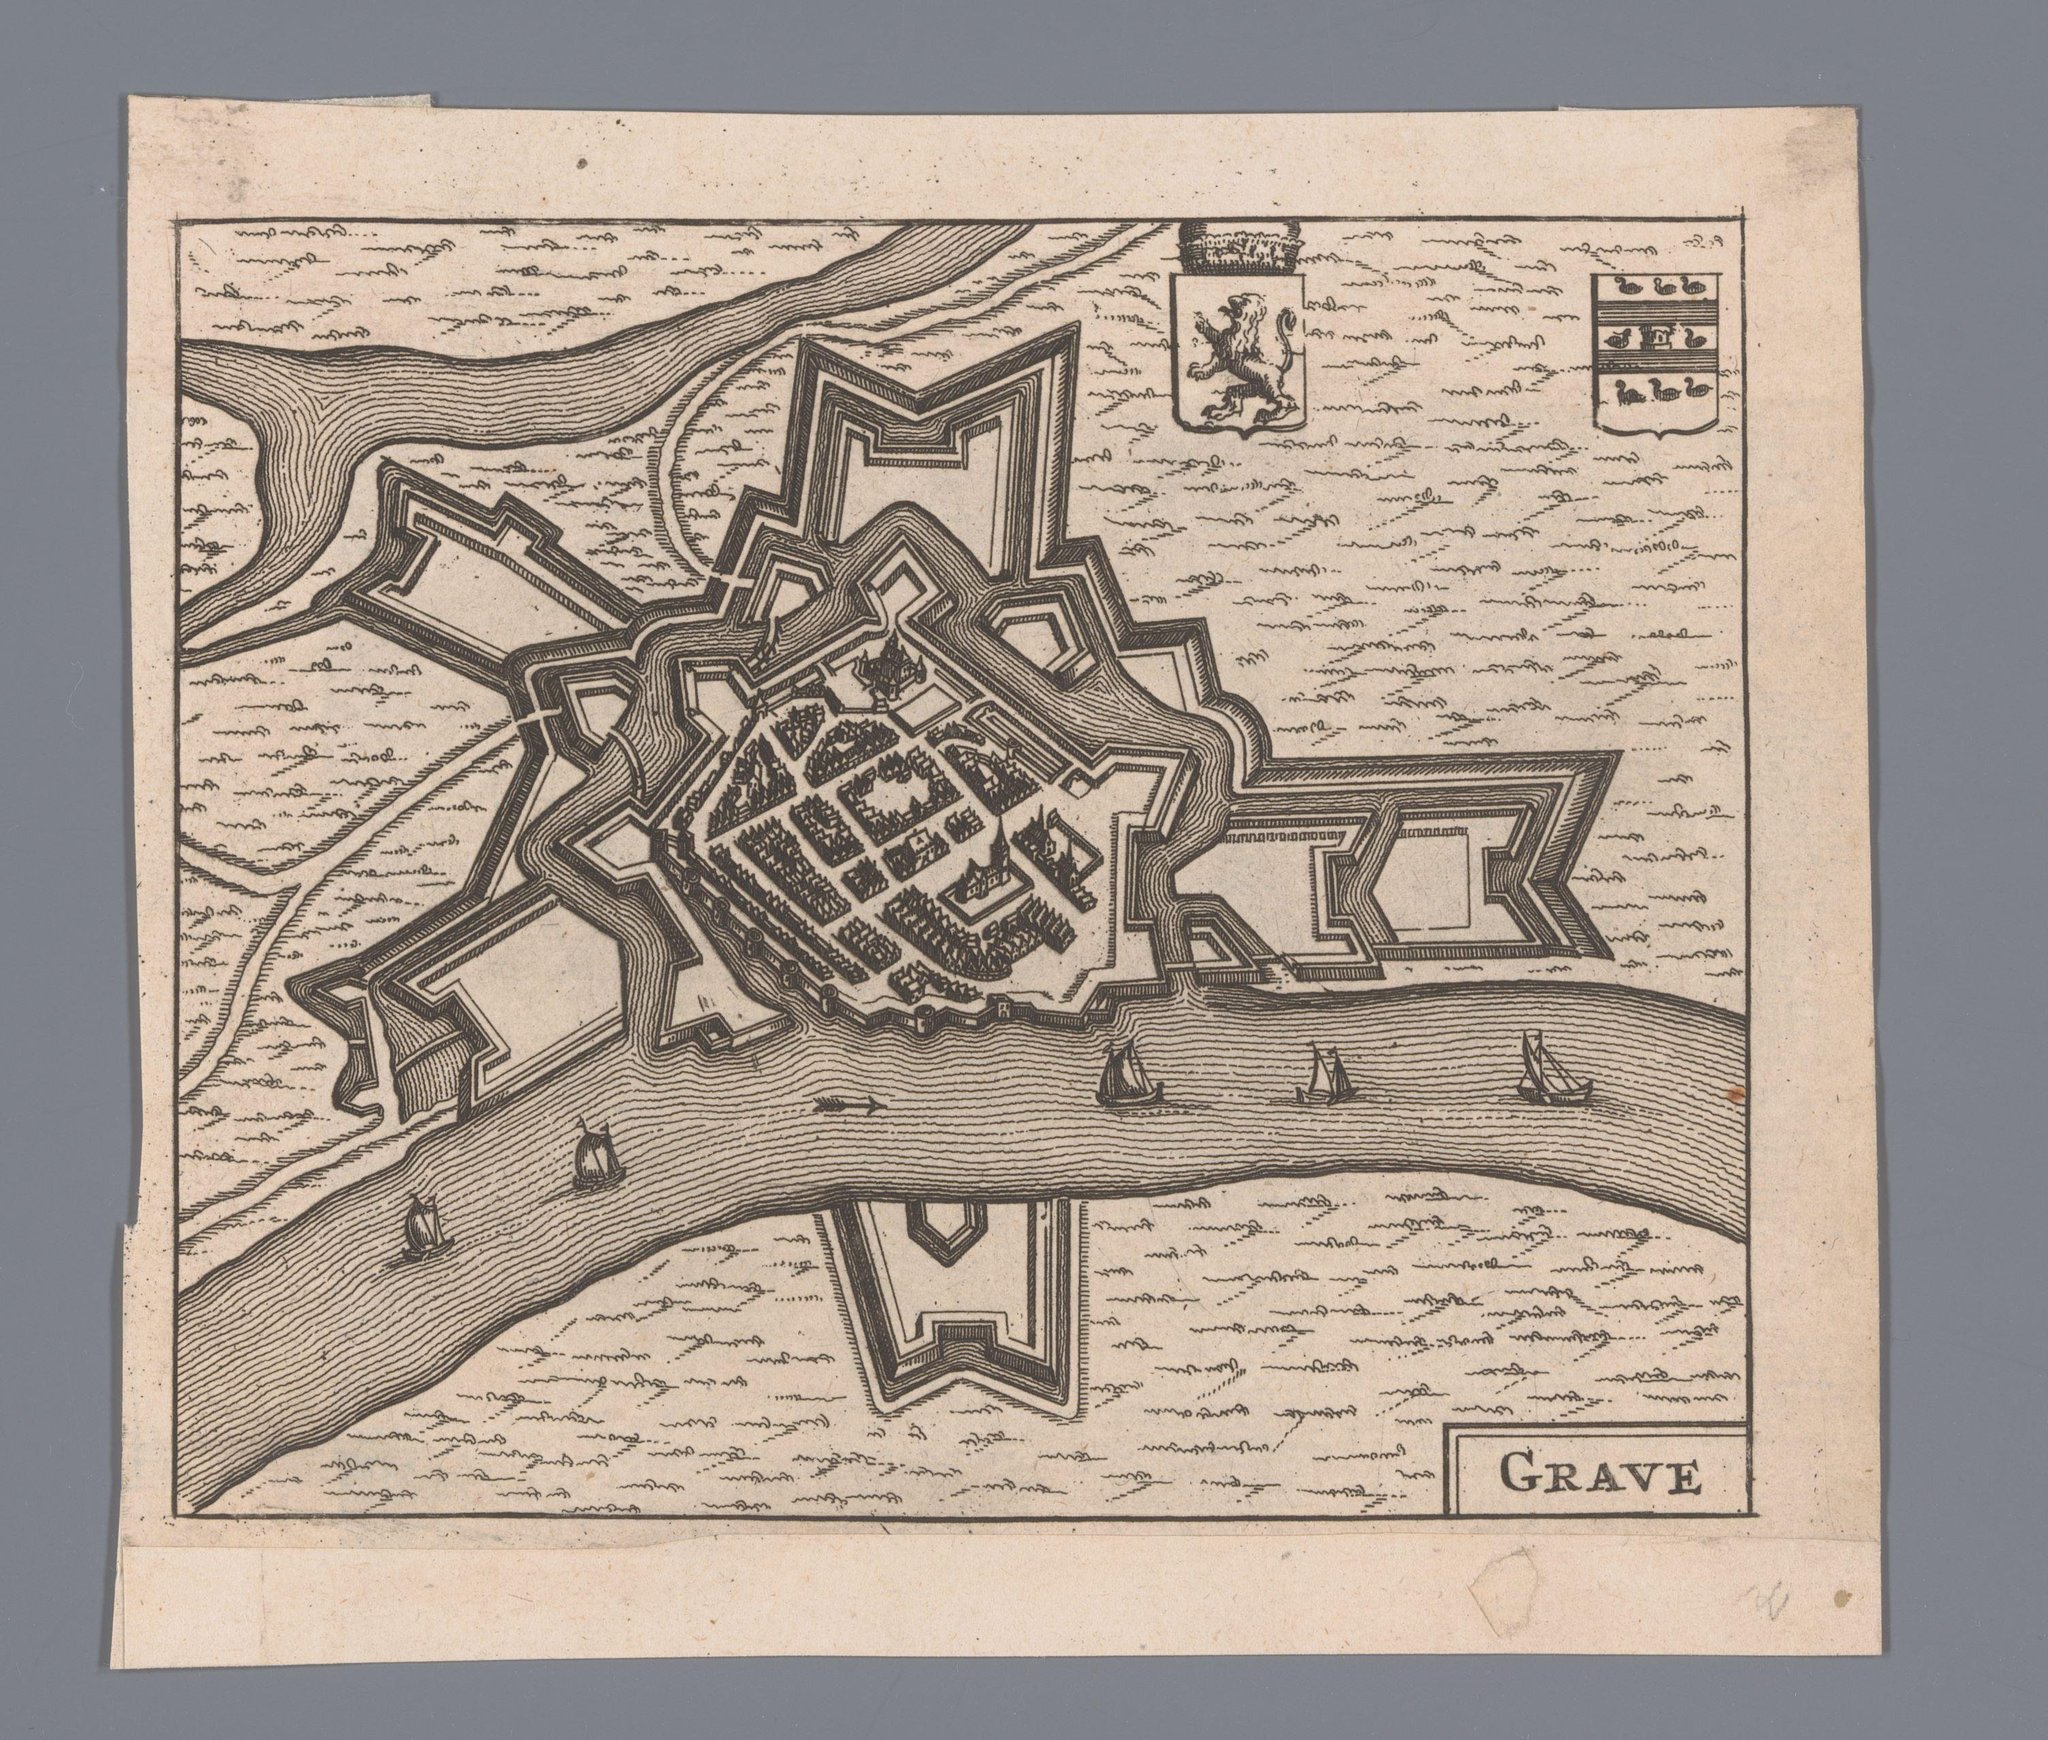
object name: area plan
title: Vestingplattegrond van Grave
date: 1660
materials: paper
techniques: engraving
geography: amsterdam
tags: maps of cities, grave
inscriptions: collector's mark: Lugt 2233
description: Prent uit: Guicciardini, Lodovico. Belgicae, sive Inferioris Germaniae descriptio (...). Amsterdam: Jacob van Meurs, 1660. Tevens gebruikt in de Nederlandse vertaling hiervan: Guicciardini, Lodovico. Beschryvingh der Neder-landen (...). Amsterdam: Jacob van Meurs, 1660 (en 1662).